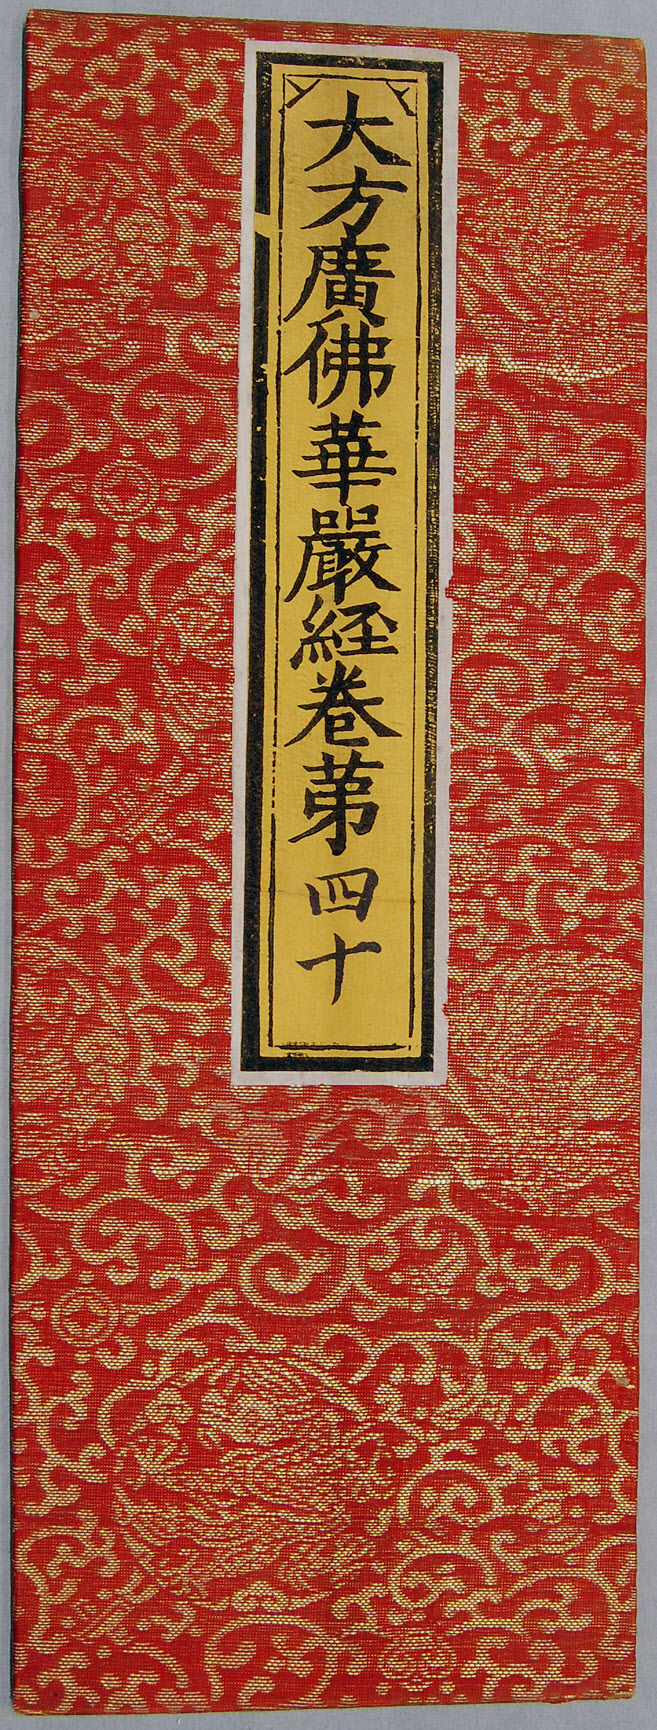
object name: sutra cover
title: Sutra Cover with Pattern of Coiled Dragon Roundels and Auspicious Motifs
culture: chinese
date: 1501-1600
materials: metal thread, silk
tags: dragons